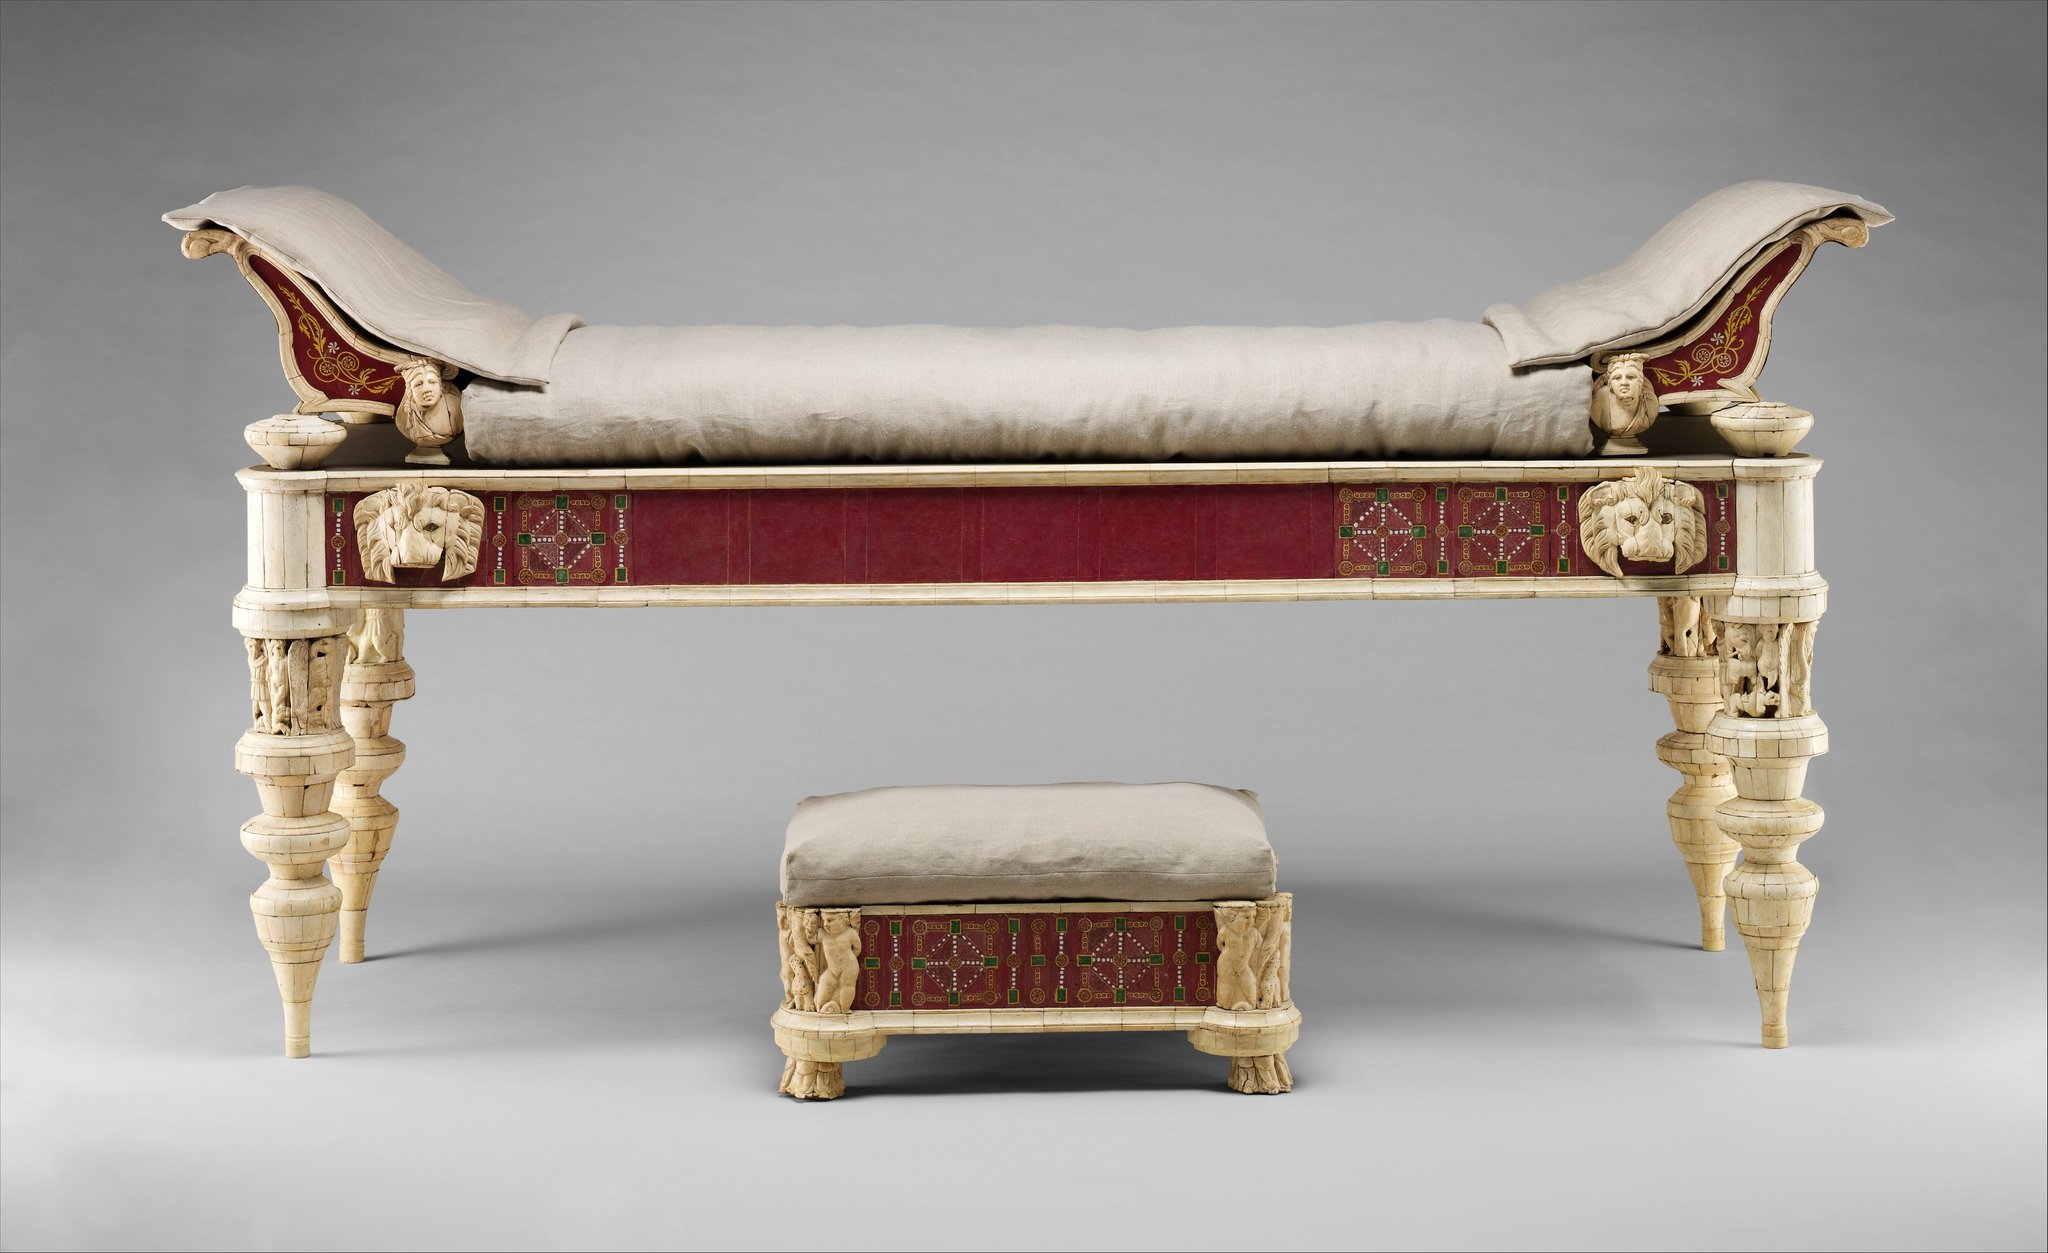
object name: couch and footstool with bone carving and glass inlay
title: Couch and footstool with bone carvings and glass inlays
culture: roman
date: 1-200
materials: bone, glass, wood